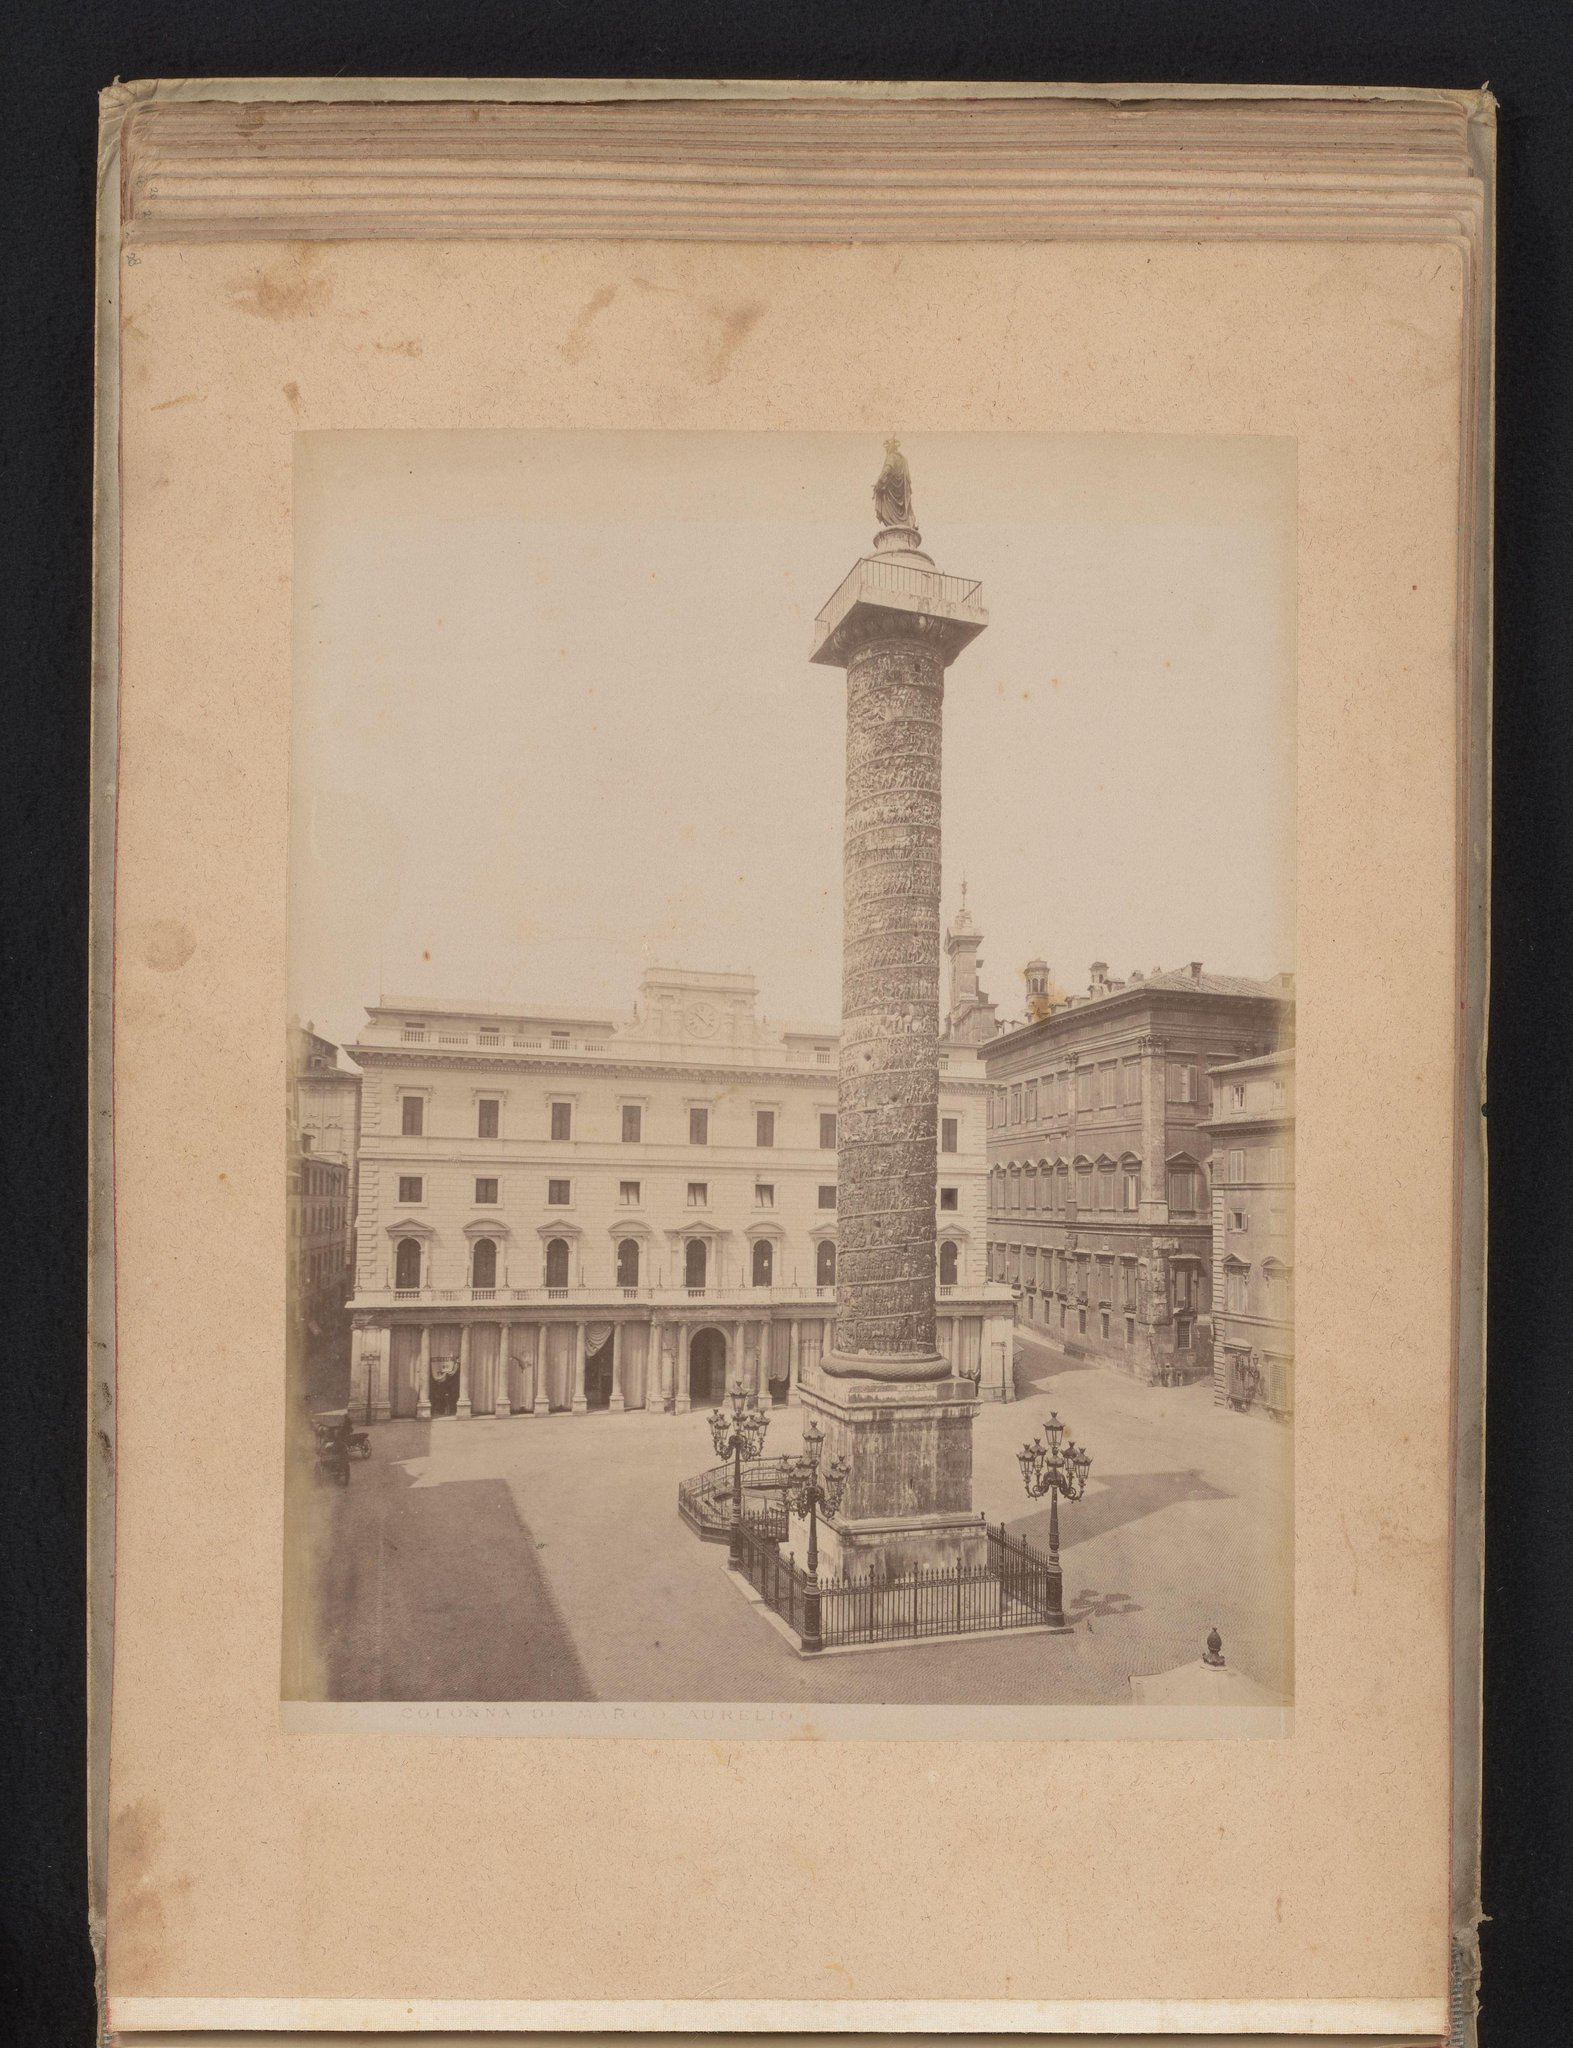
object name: photograph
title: Gezicht op de zuil van Marcus Aurelius op de Piazza Colonna in Rome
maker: Anonymous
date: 1870-1895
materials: cardboard, photographic support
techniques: albumen print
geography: rome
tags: triumphal column with helical friezes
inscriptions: inscription: ‘[.]32 COLONNA DI MARCO AURELIO’